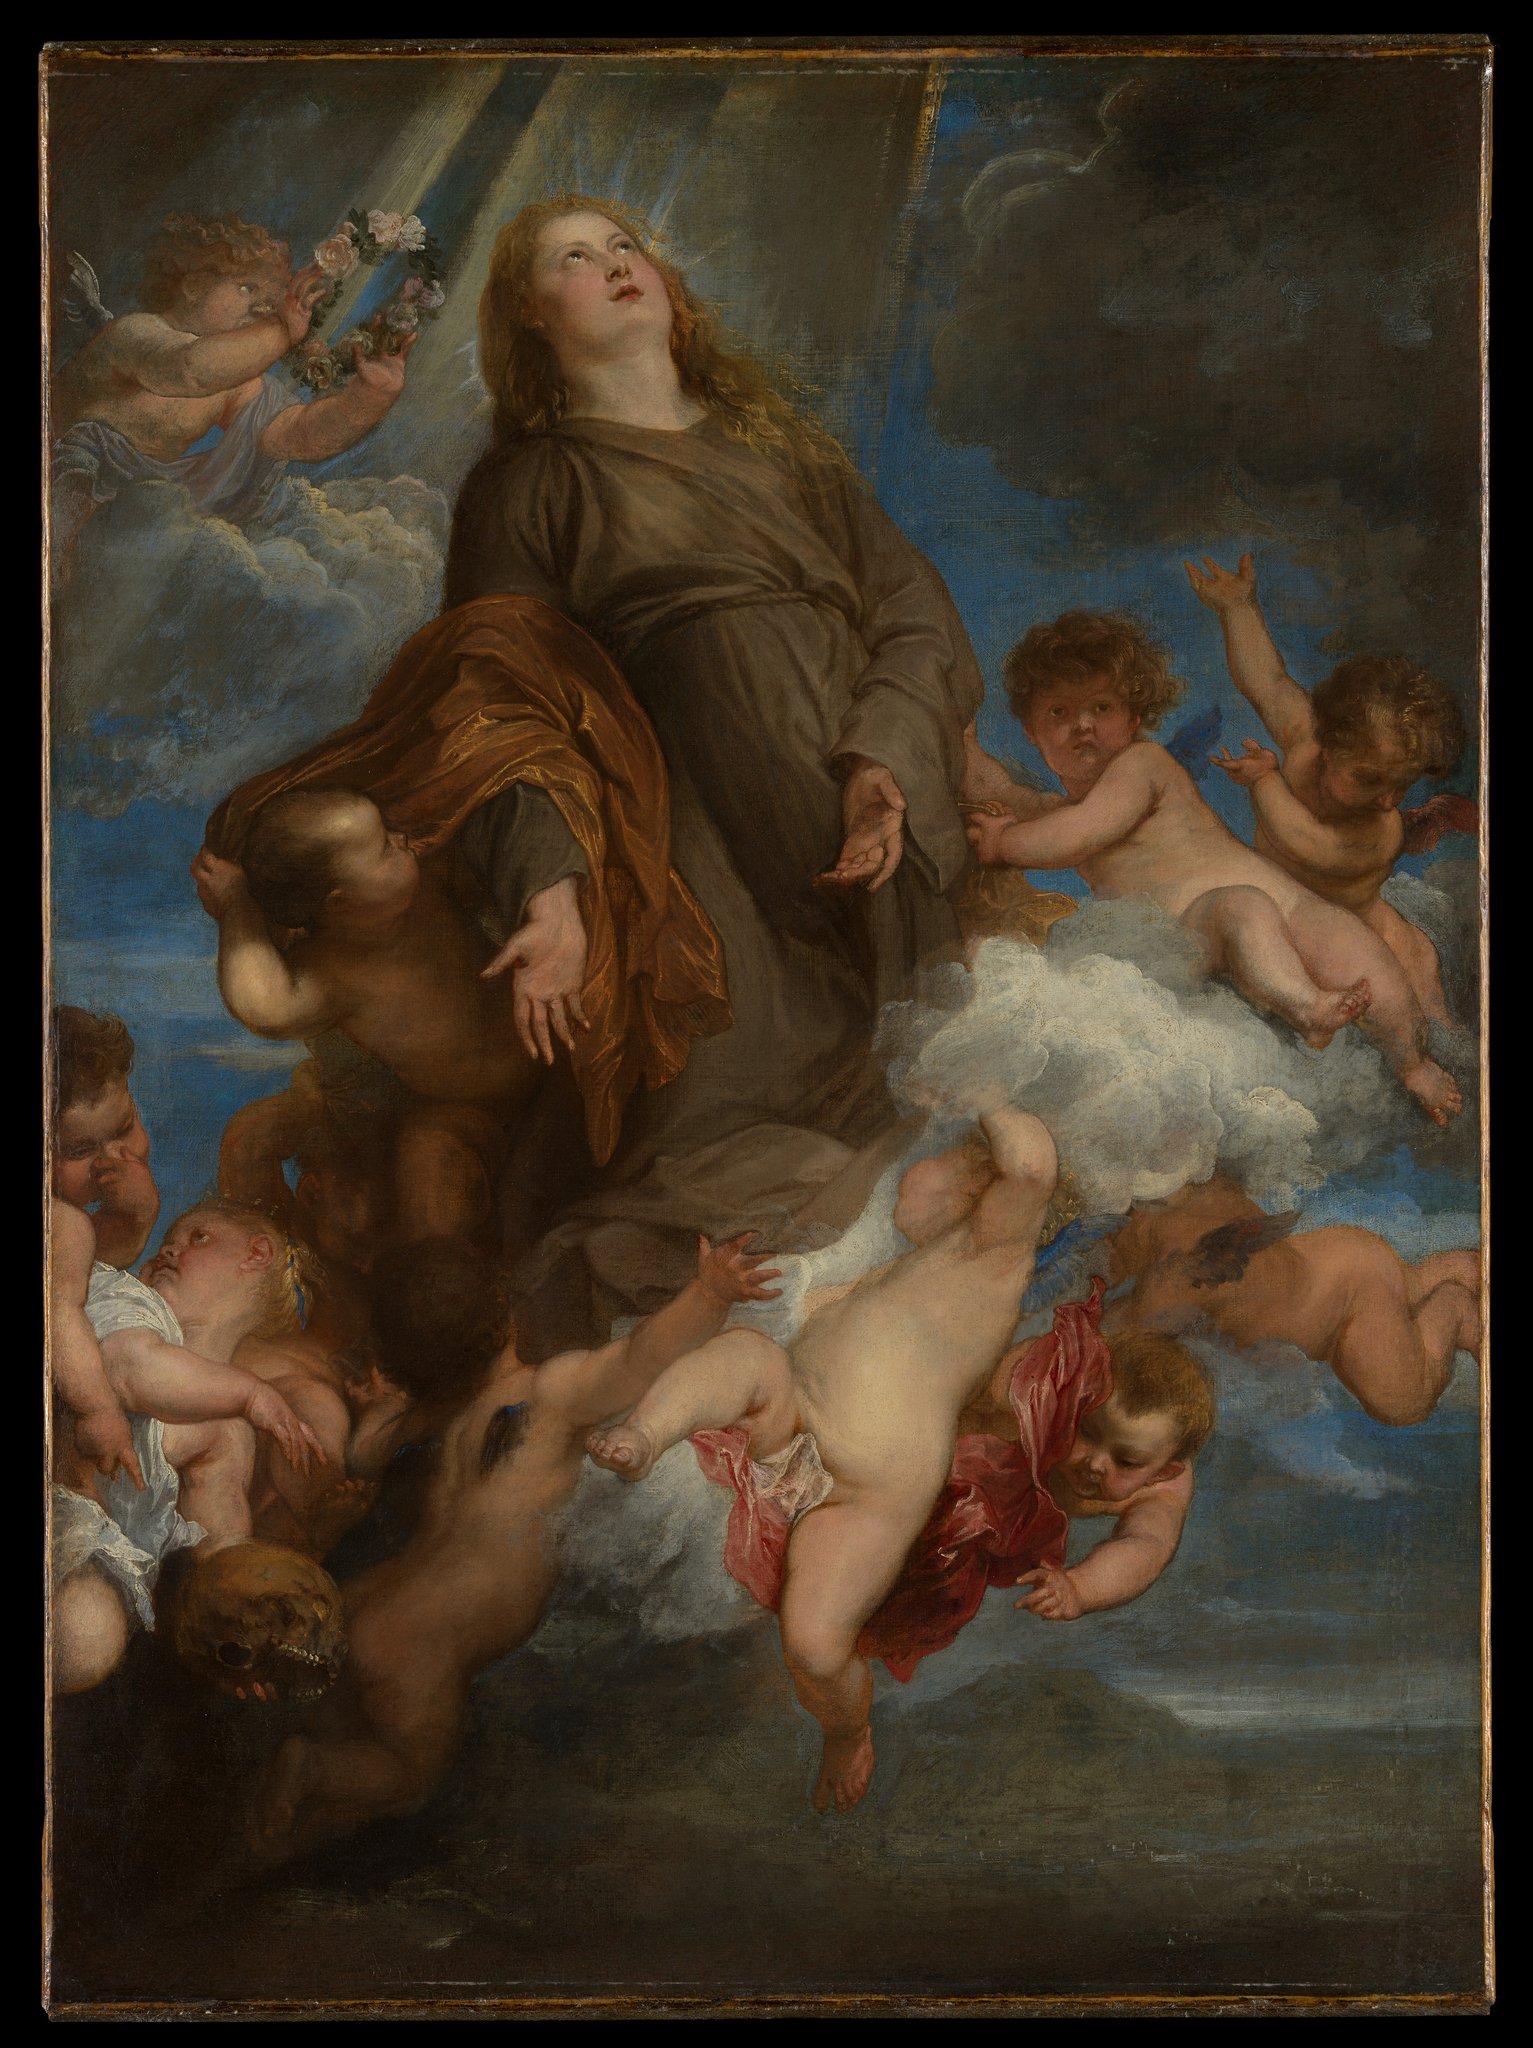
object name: painting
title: Saint Rosalie Interceding for the Plague-stricken of Palermo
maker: anthony van dyck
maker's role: artist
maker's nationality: flemish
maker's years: 1599-1641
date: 1624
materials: canvas, oil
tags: women,putti,saints